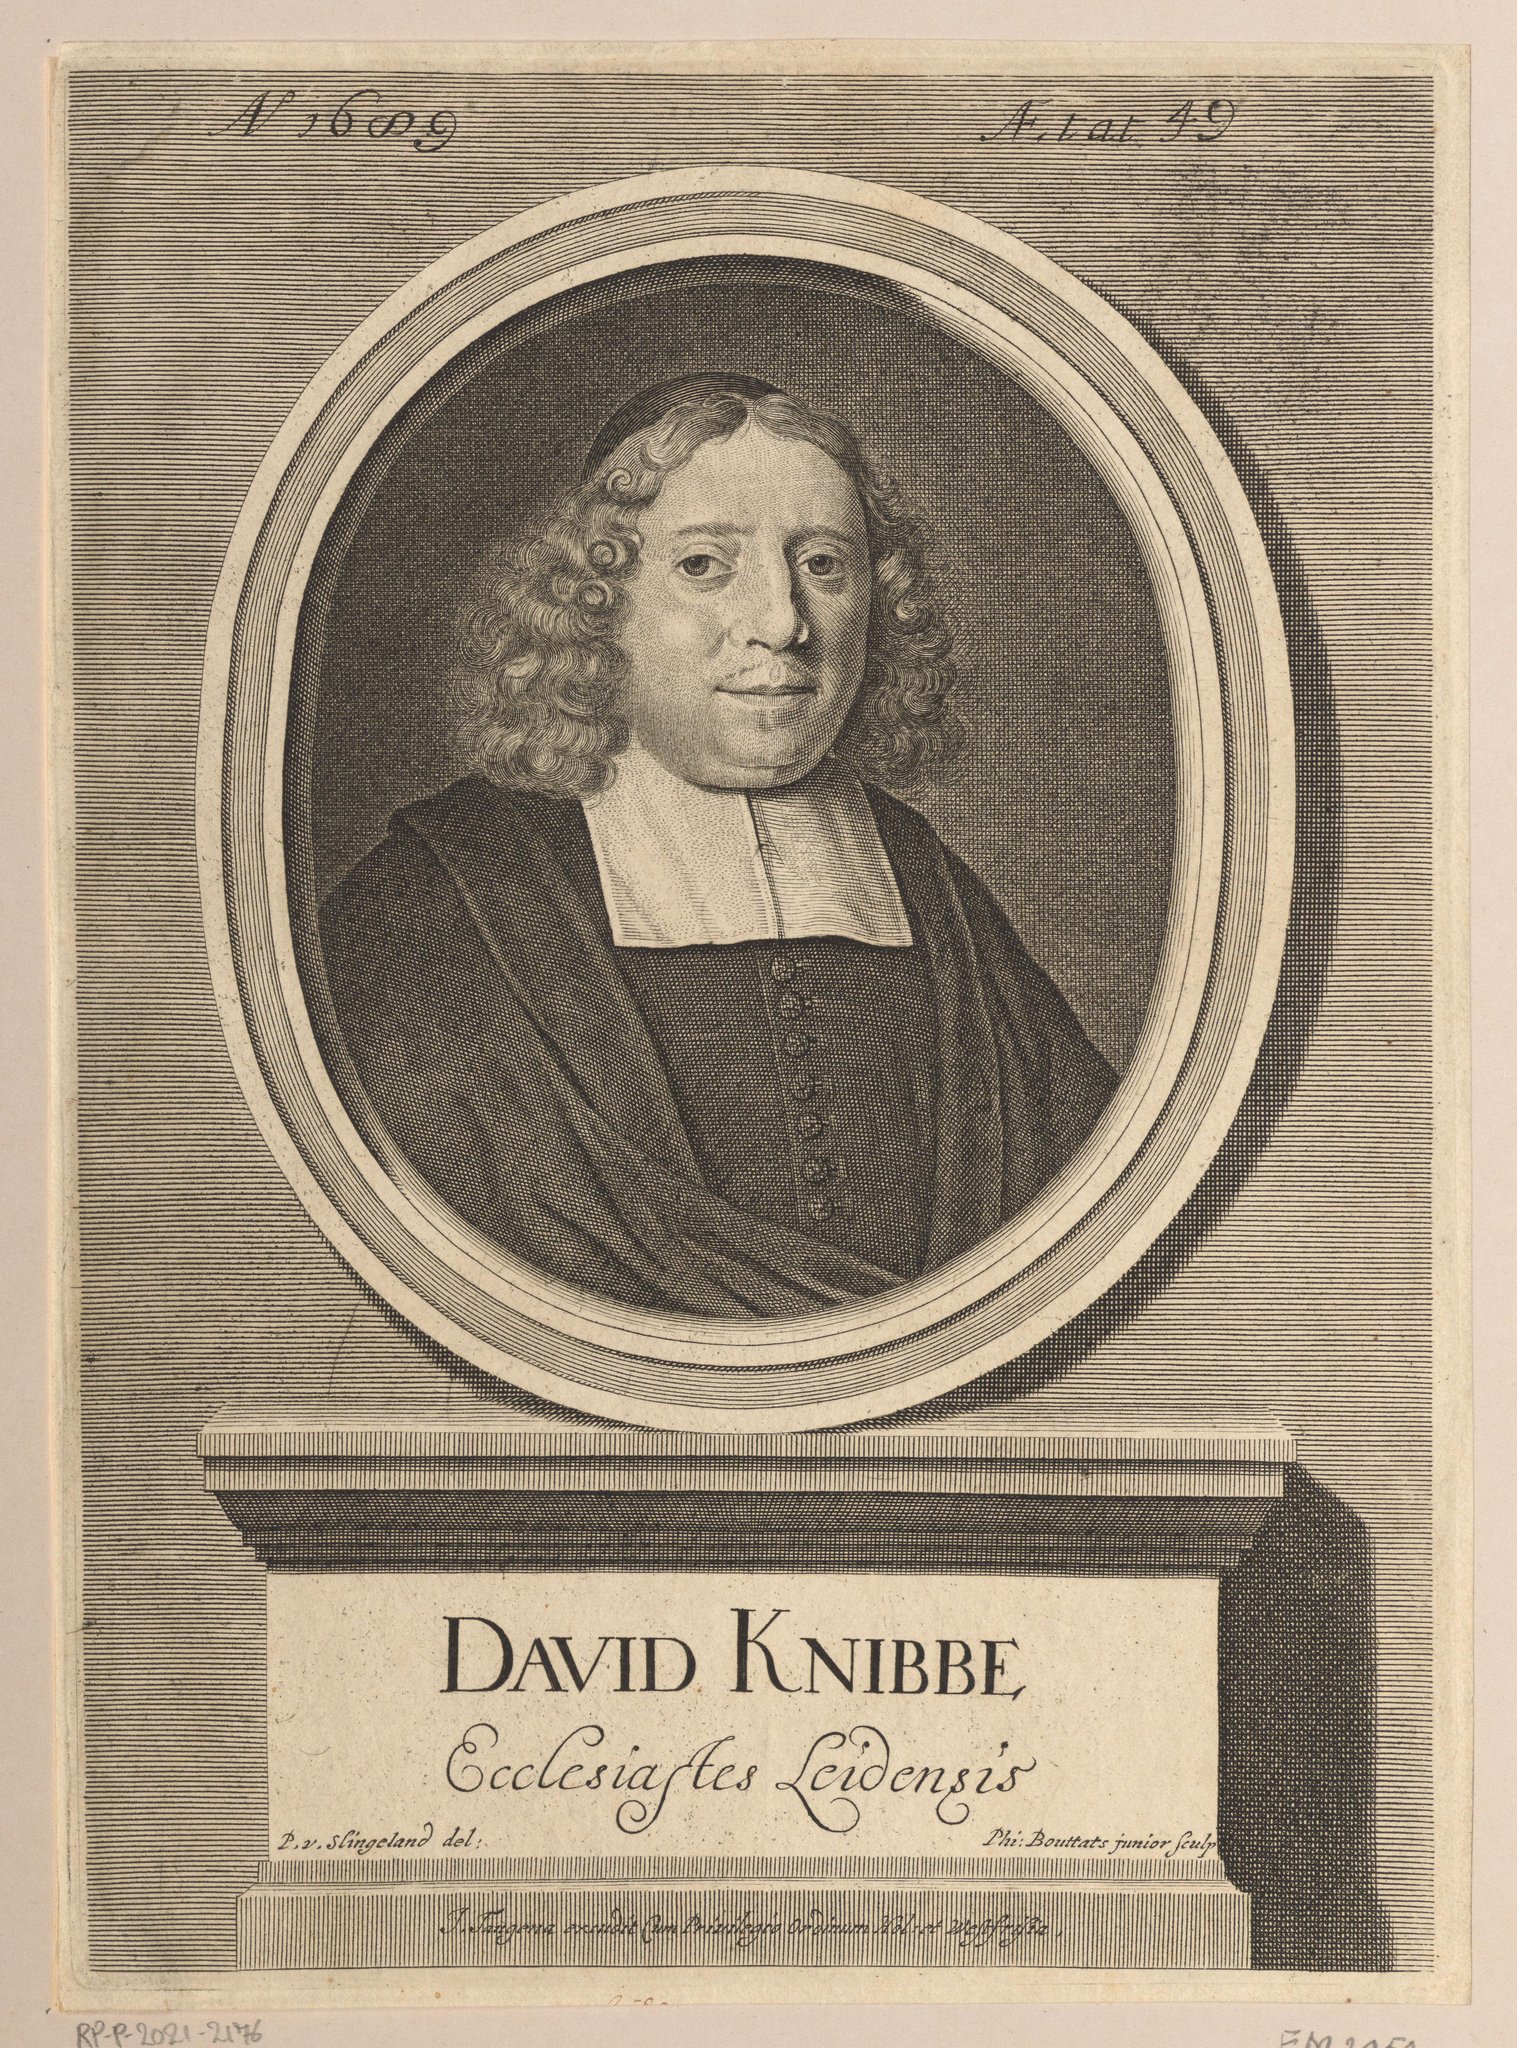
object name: print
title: Portret van David Knibbe op 49-jarige leeftijd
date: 1689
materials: paper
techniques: engraving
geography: west frisia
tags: historical persons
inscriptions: date